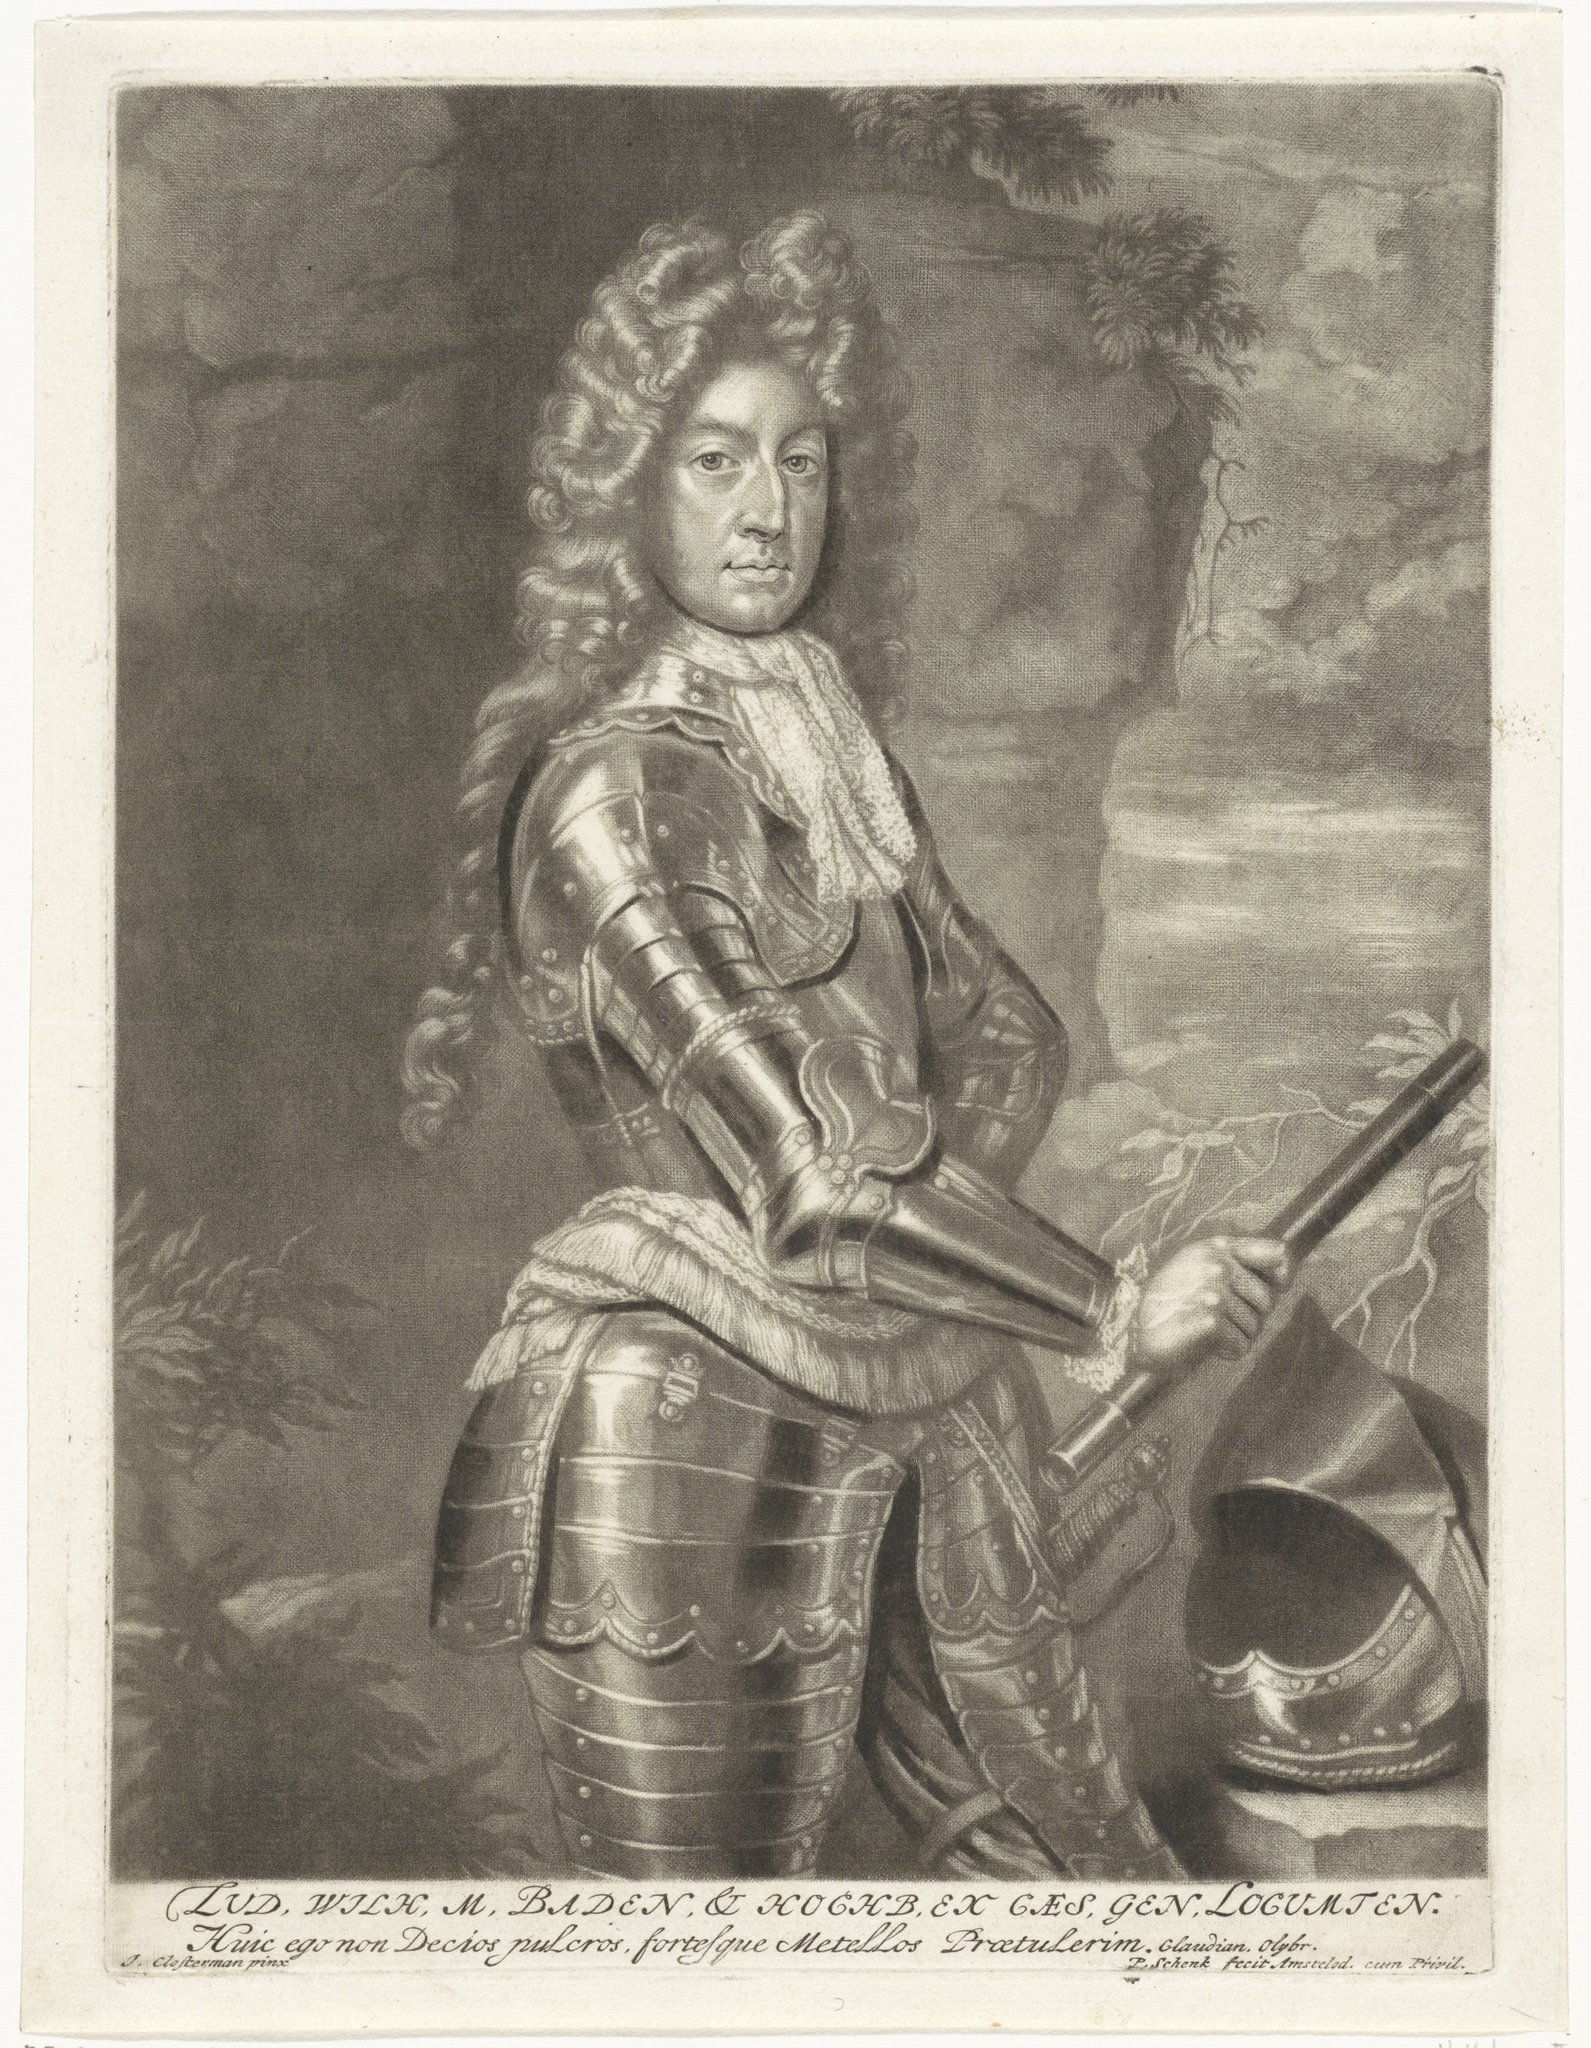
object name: print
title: Portret van Ludwig Wilhelm von Baden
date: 1670-1713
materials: paper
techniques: engraving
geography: amsterdam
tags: paris, armour, wig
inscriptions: collector's mark: Lugt 2166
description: De luitenant-generaal Ludwig Wilhelm, markgraaf van Baden. Hij draagt een harnas en een lange krulpruik.